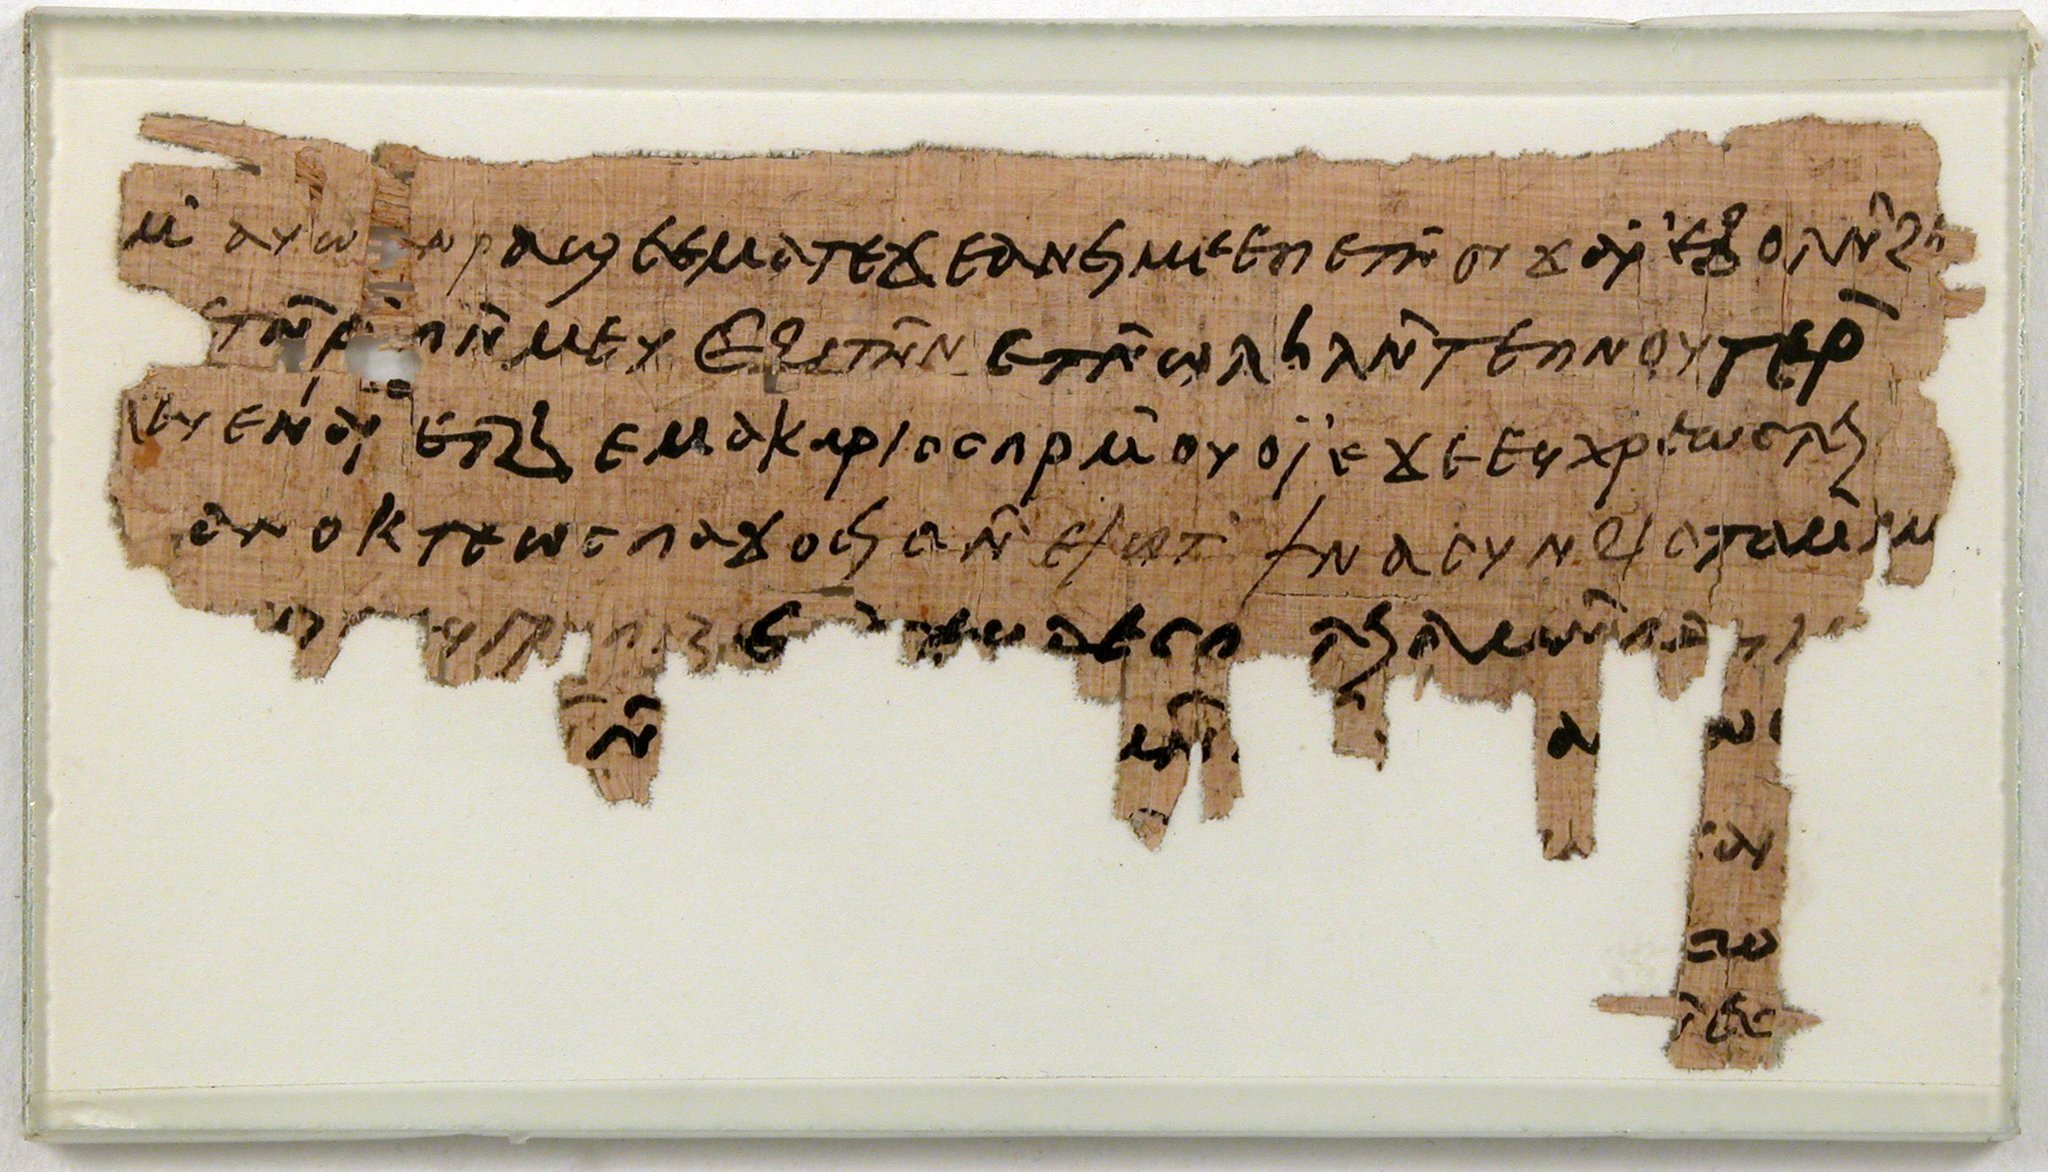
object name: fragment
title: Papyrus Fragment of a Letter from Joseph to Epiphanius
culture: coptic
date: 601-700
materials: ink, papyrus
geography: egypt